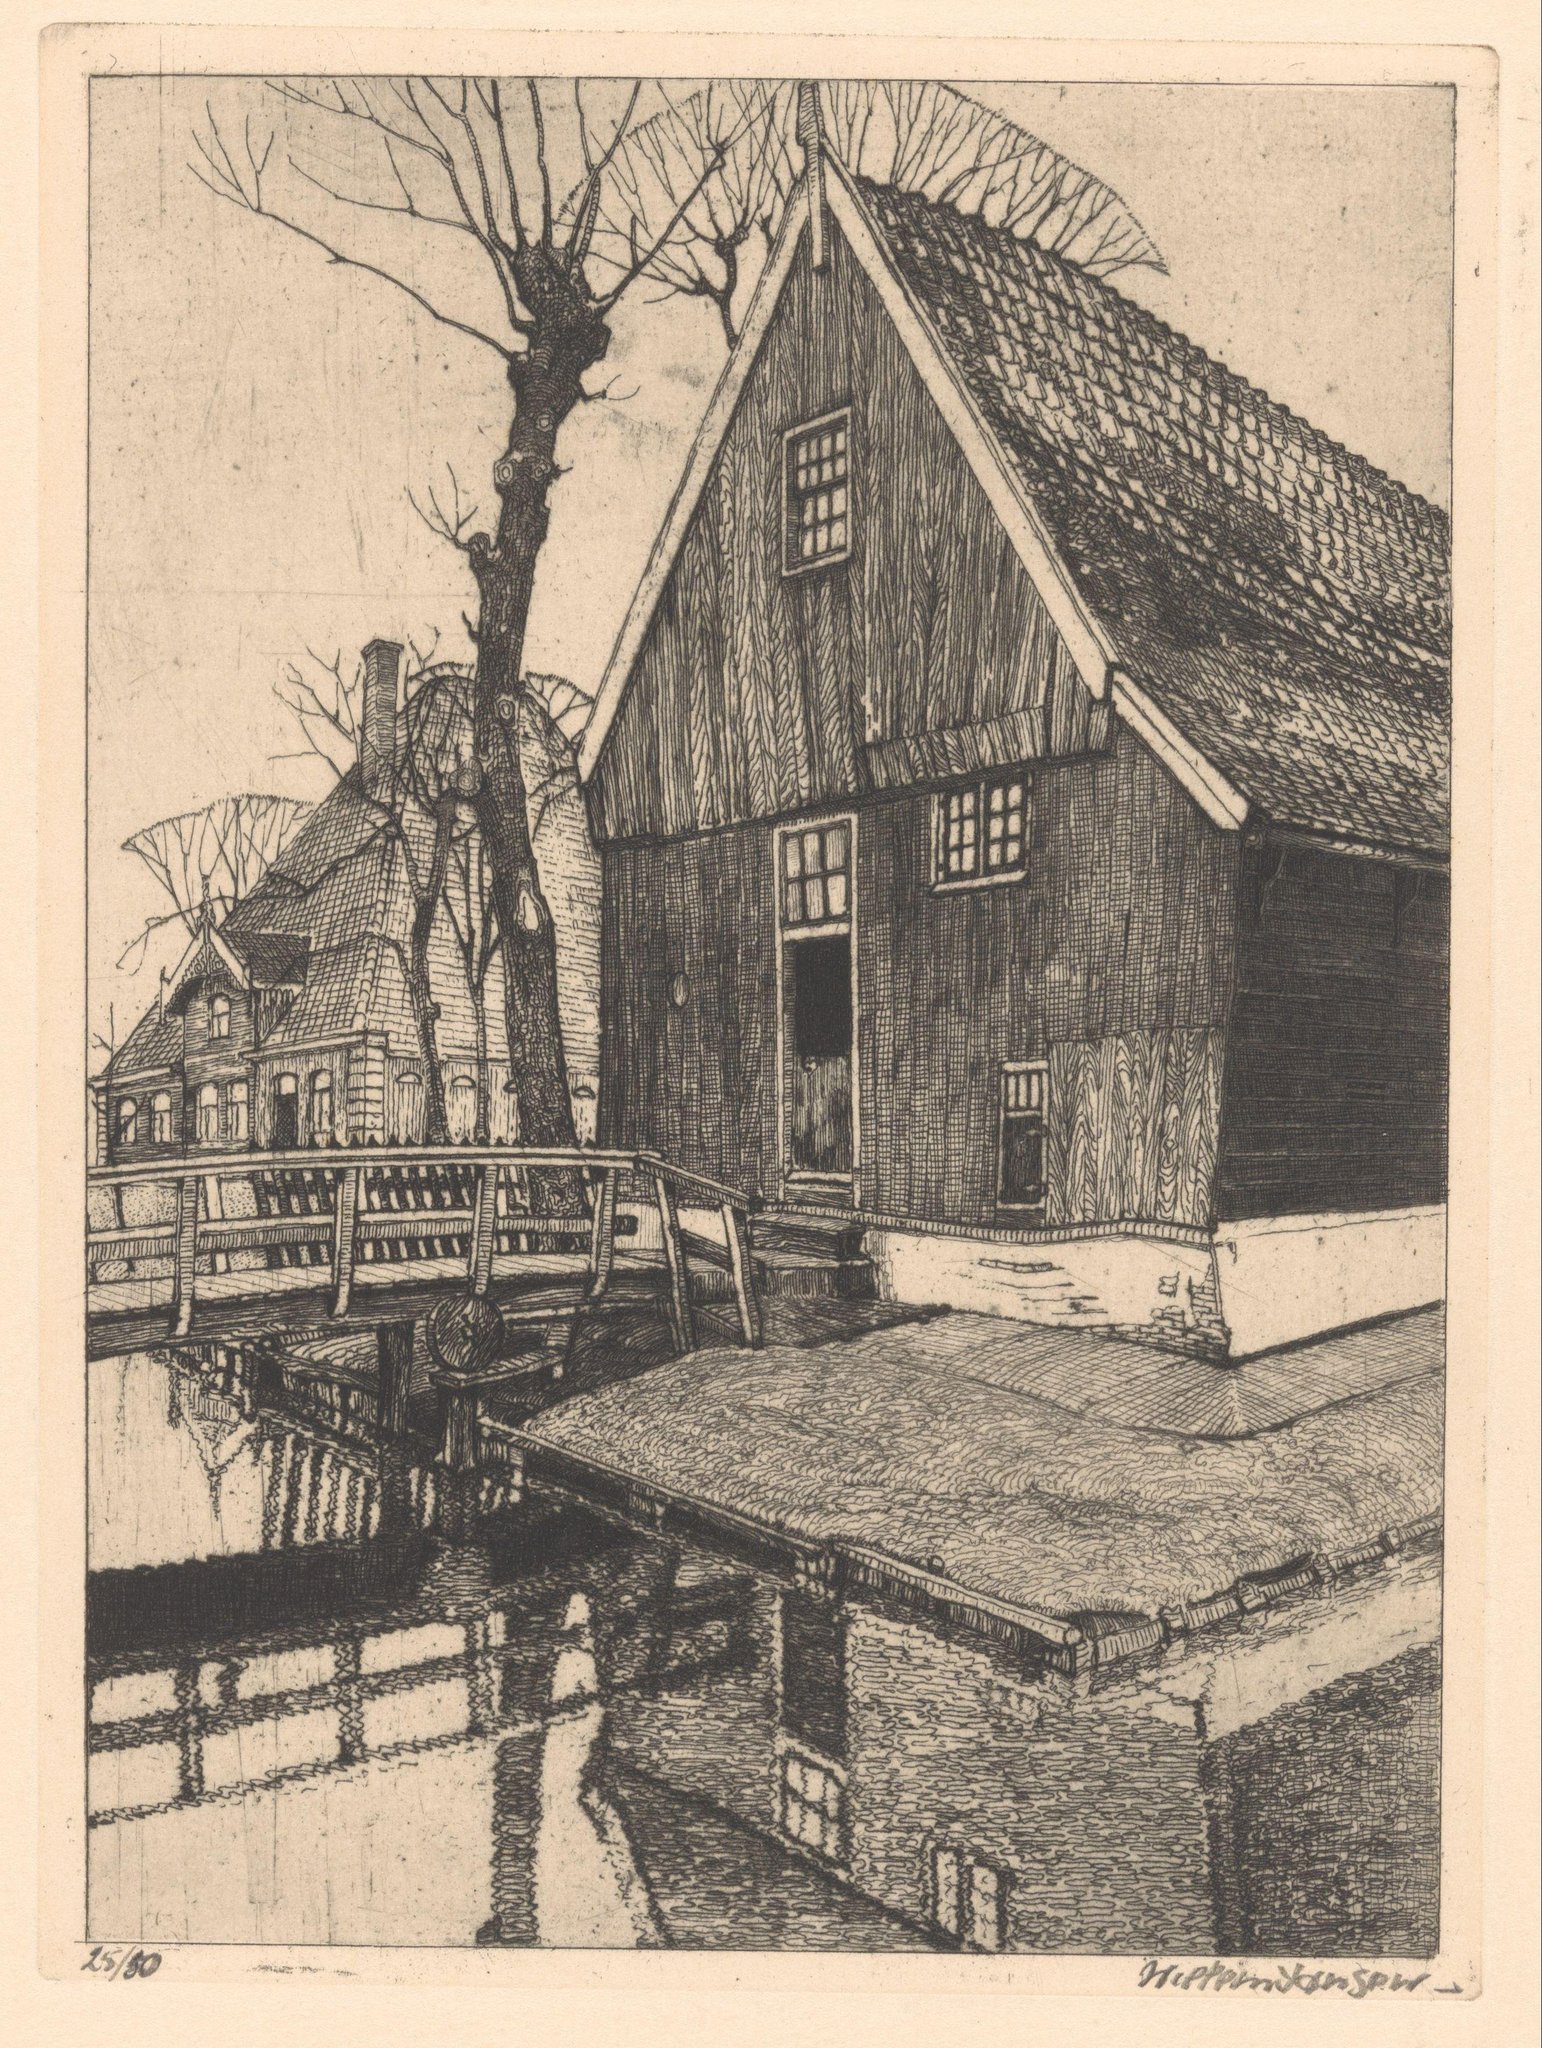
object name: print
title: Bakkerij te Assendelft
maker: willem jansen (graveur)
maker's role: print maker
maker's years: 1892-1969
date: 1902-1931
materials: paper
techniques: etching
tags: rural housing, e.g. country-house, villa, cottage, bridge, assendelft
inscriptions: collector's mark: Lugt 2228